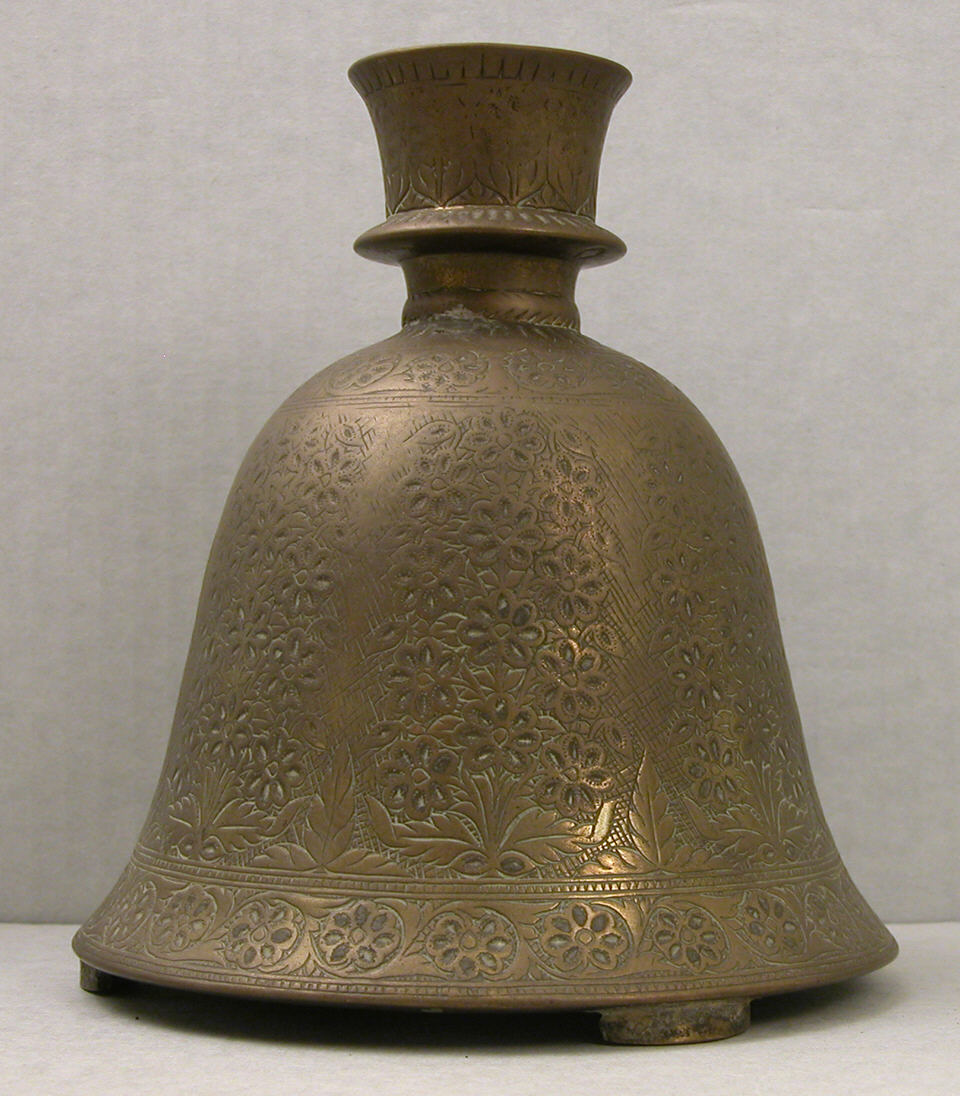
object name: water pipe base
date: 1801-1900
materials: brass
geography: india